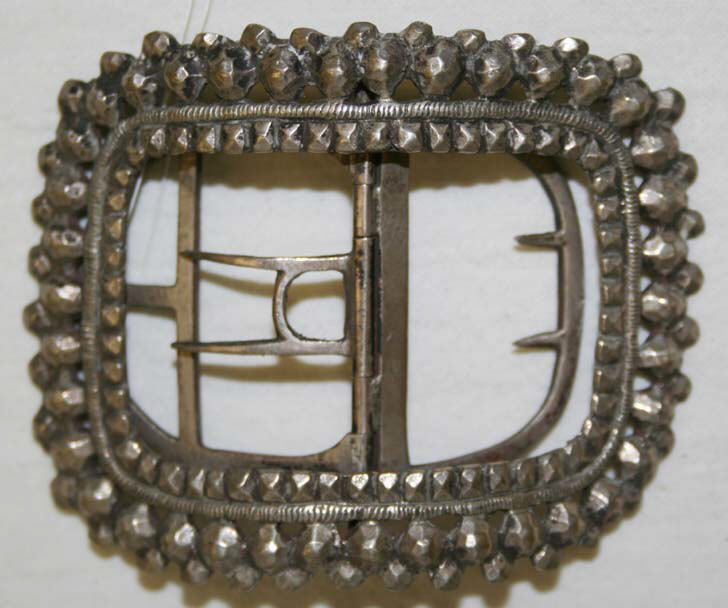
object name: shoe buckle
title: Shoe buckles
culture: french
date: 1701-1800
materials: metal